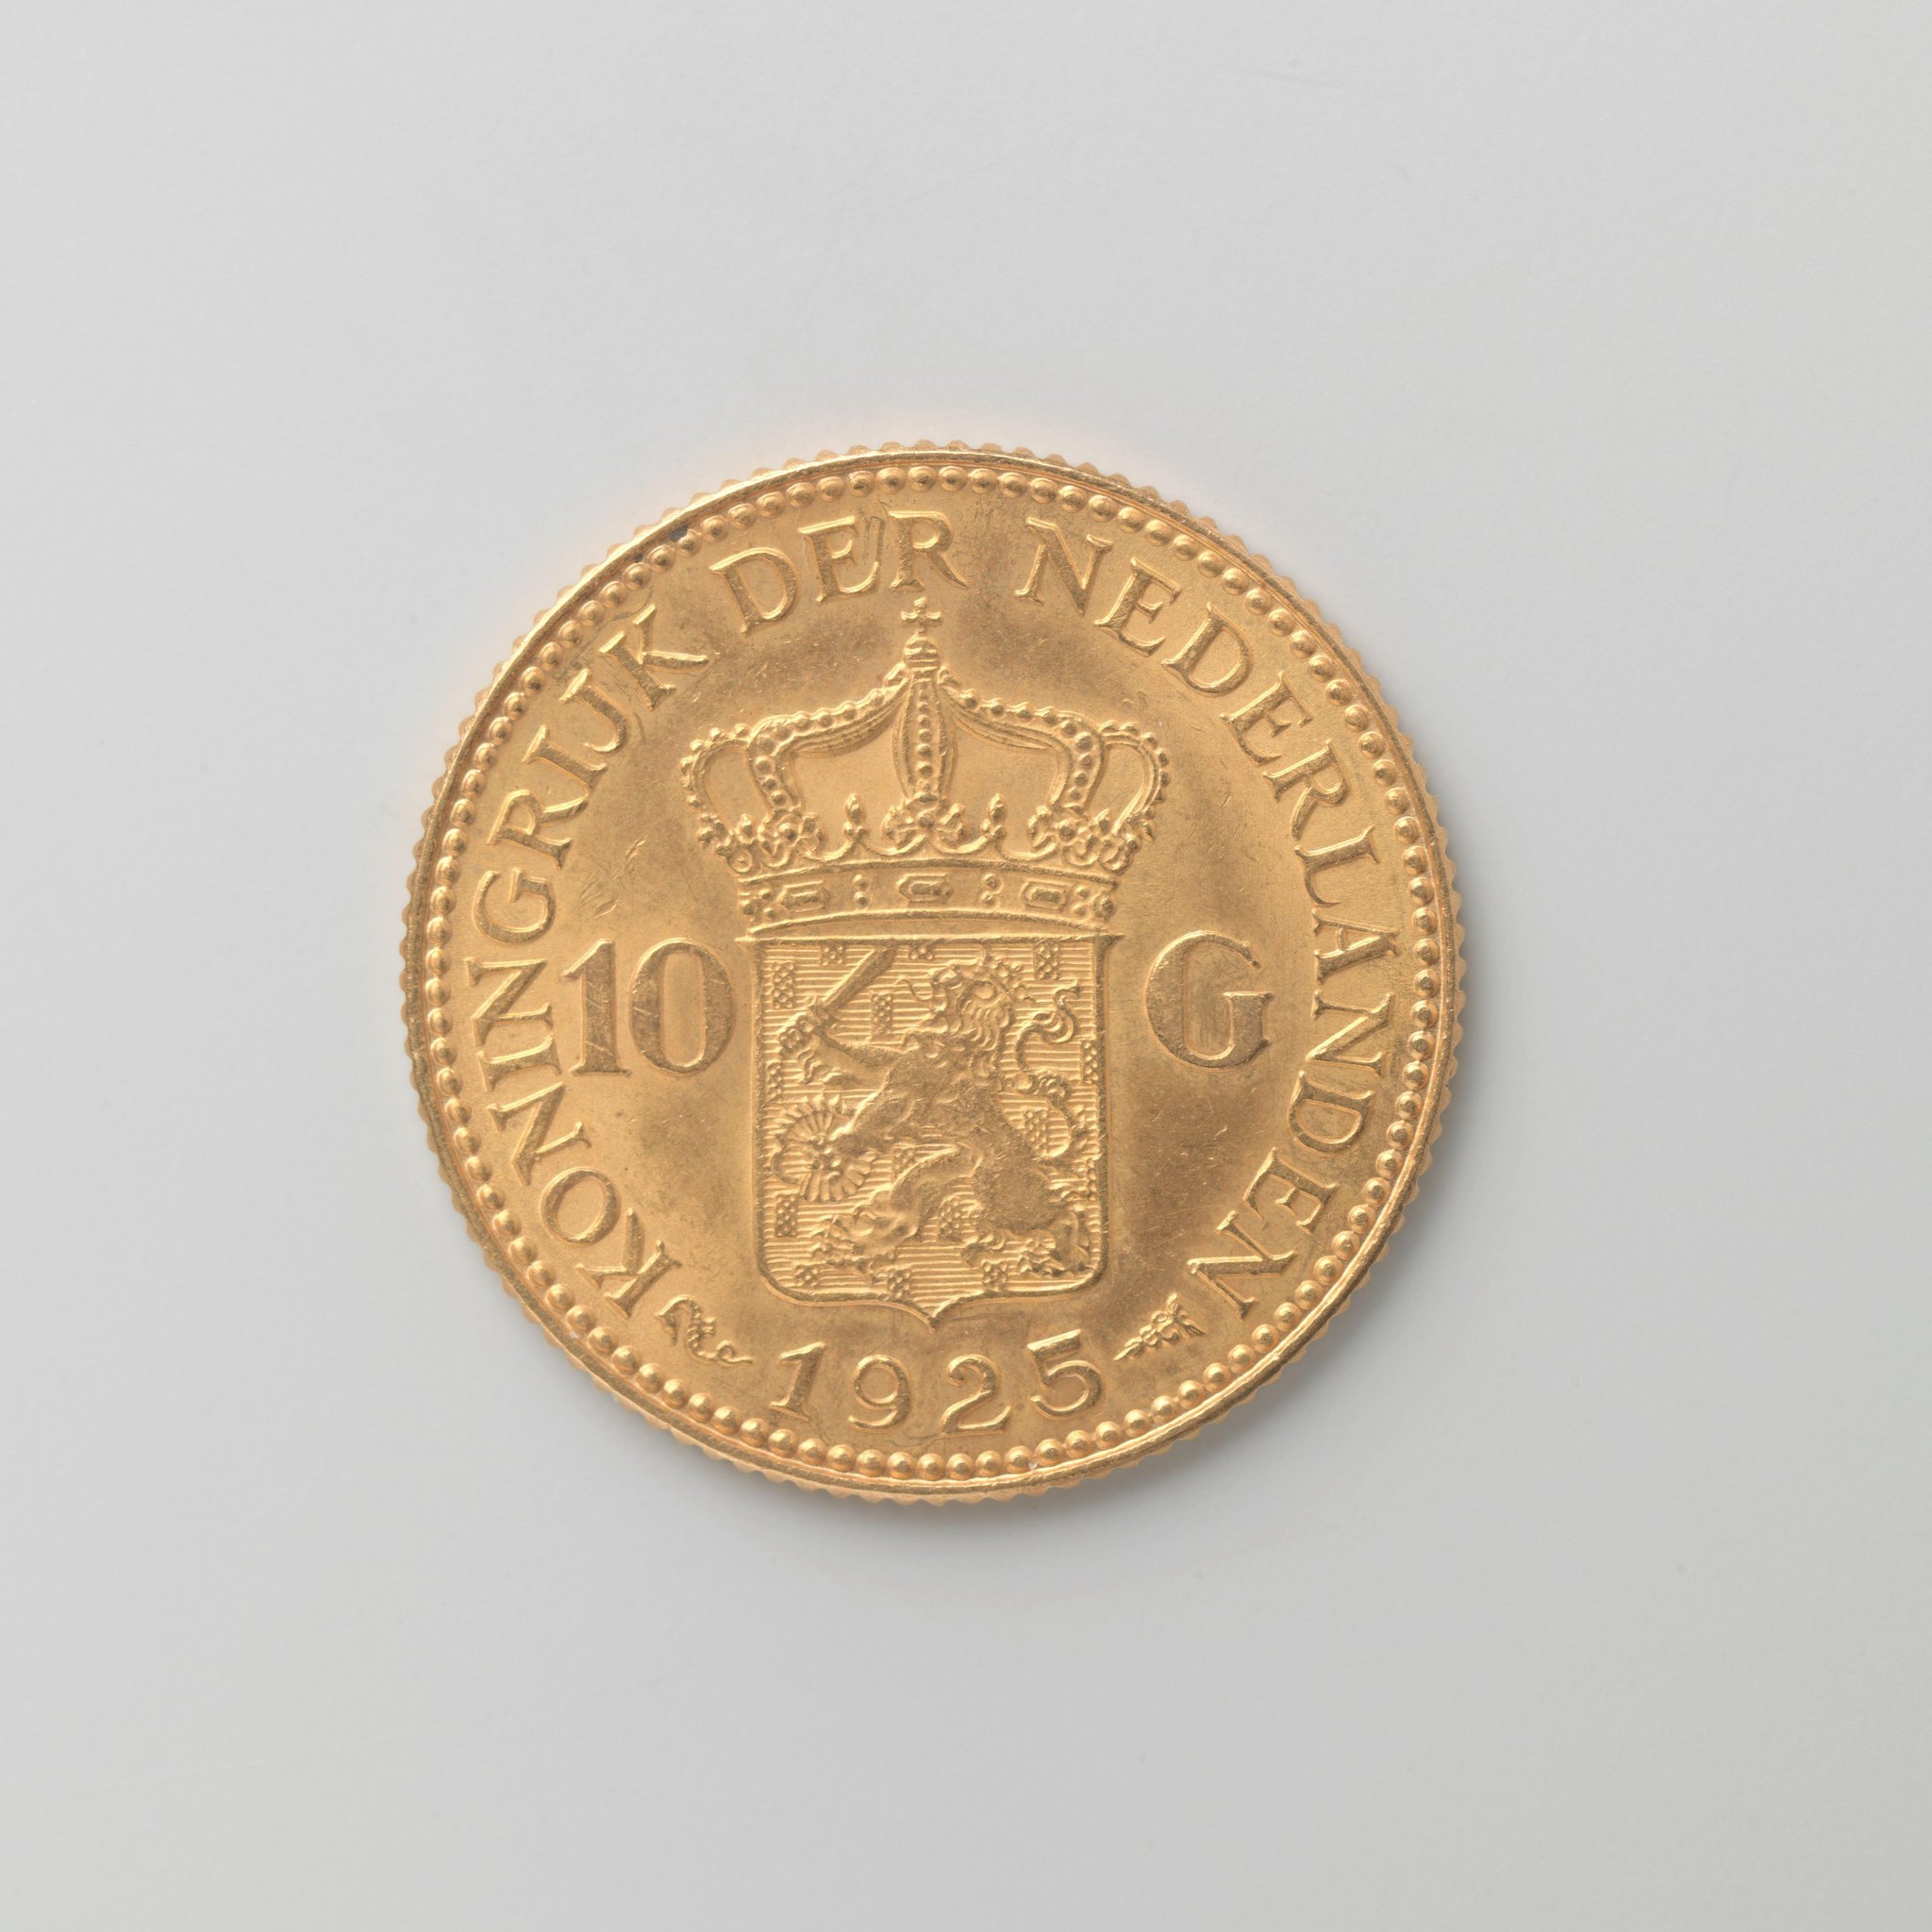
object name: tien gulden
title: Nederlandse10 gulden, 1925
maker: wilhelmina of the netherlands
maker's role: print maker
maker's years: 1880-1962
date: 1925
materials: gold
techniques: striking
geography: utrecht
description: Gouden munt. Voorzijde: hoofd naar rechts. Keerzijde: tussen waarde-aanduiding 10 G gekroond rijkswapenschild. Jaartal onderaan in omschrift. Kartelrand.